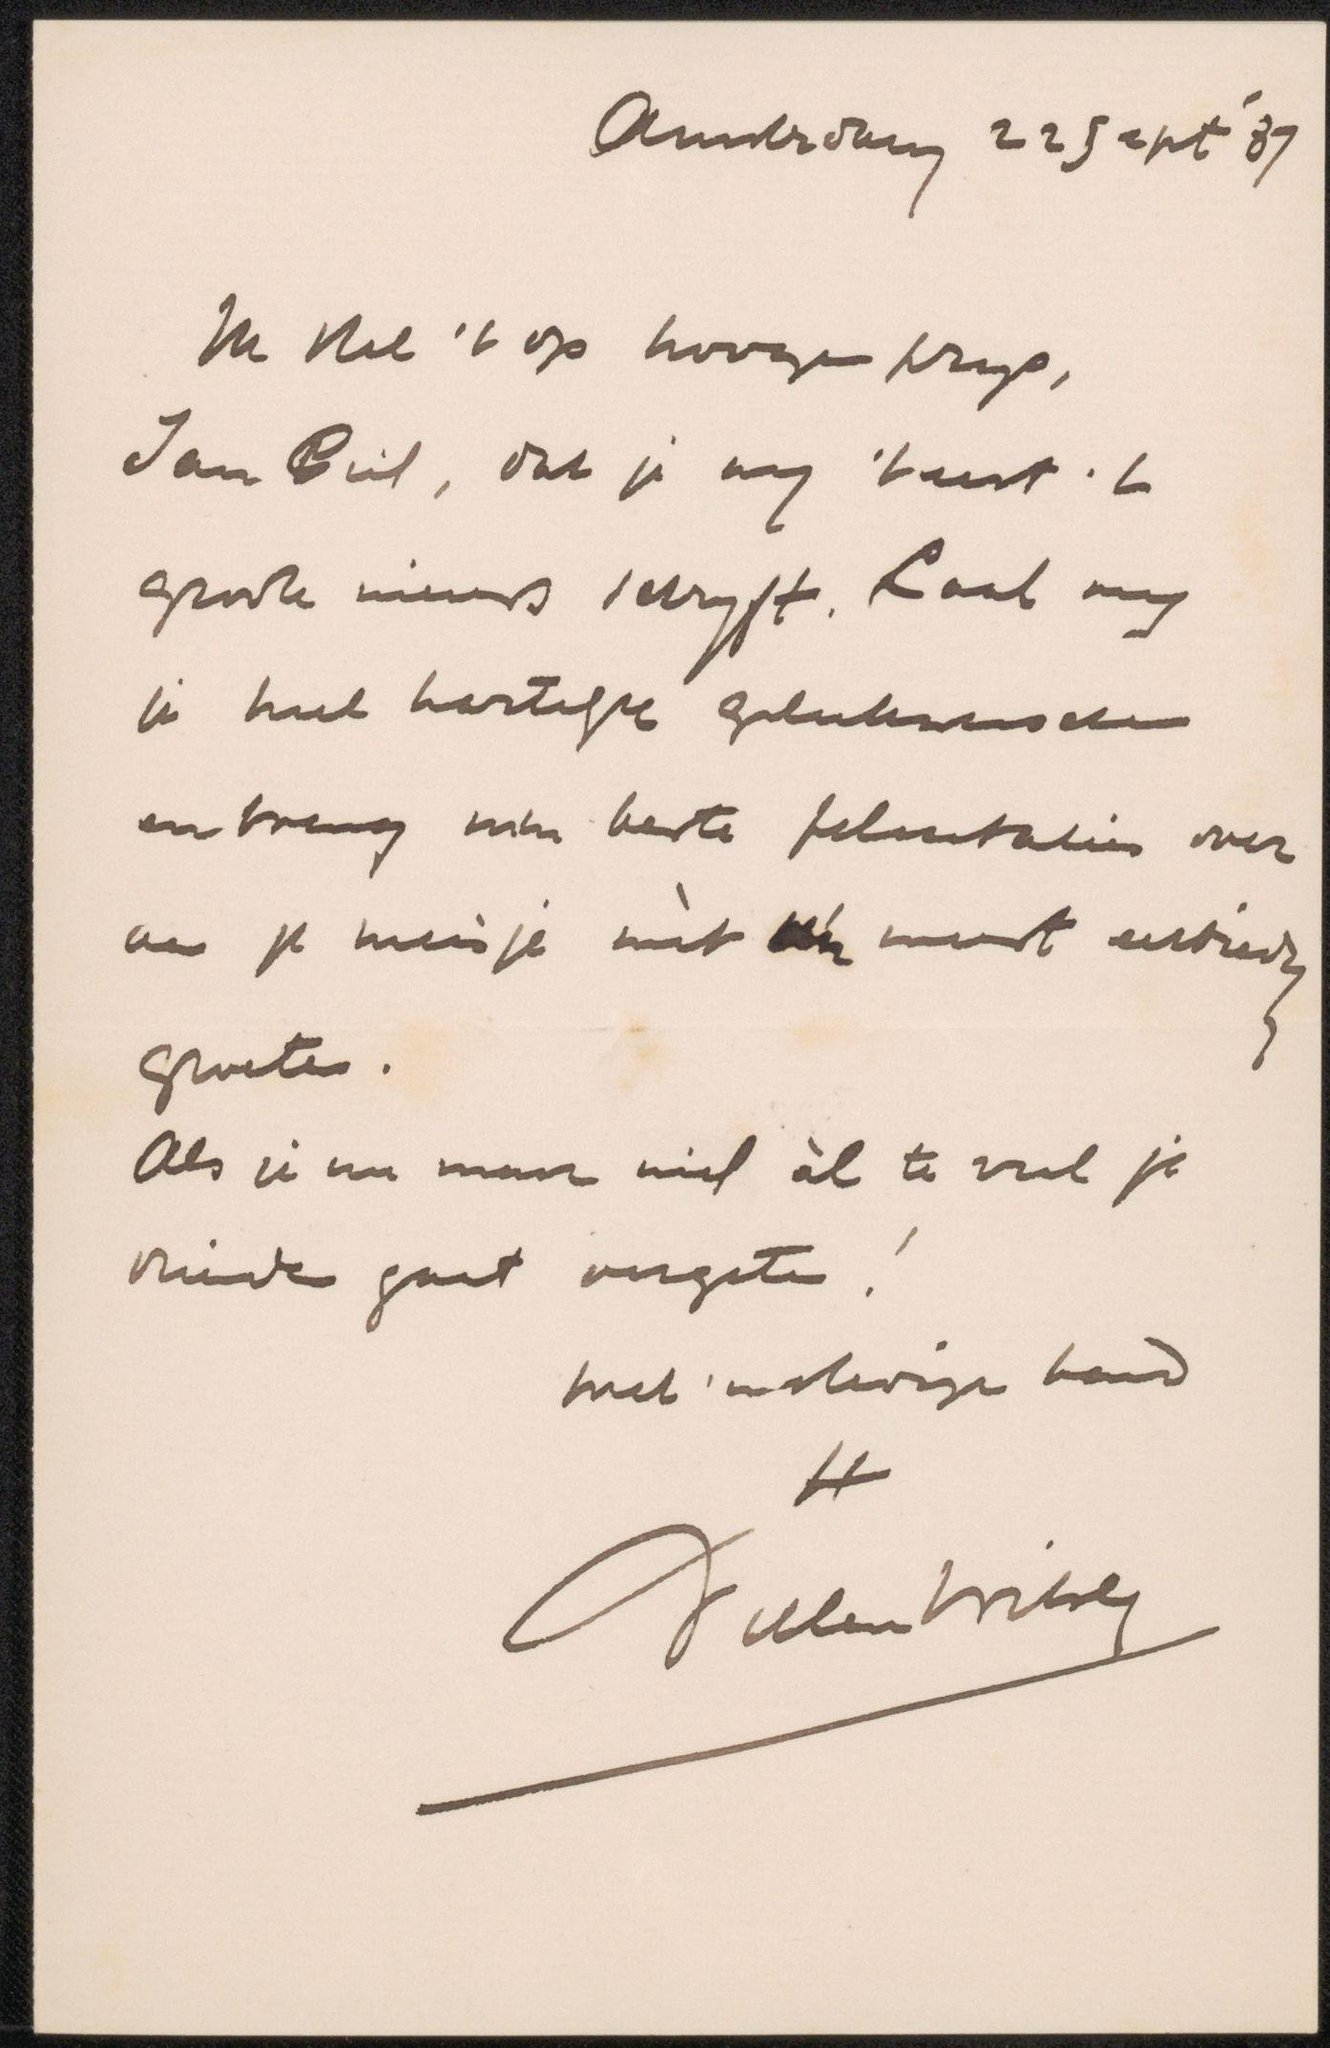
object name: letter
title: Brief aan Jan Veth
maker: willem witsen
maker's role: draughtsman, painter, print maker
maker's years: 1860-1923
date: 1887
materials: ink, paper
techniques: pen, writing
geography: amsterdam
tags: dordrecht, designer, jan veth, family life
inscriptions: watermark, collector's mark: ‘RPK’